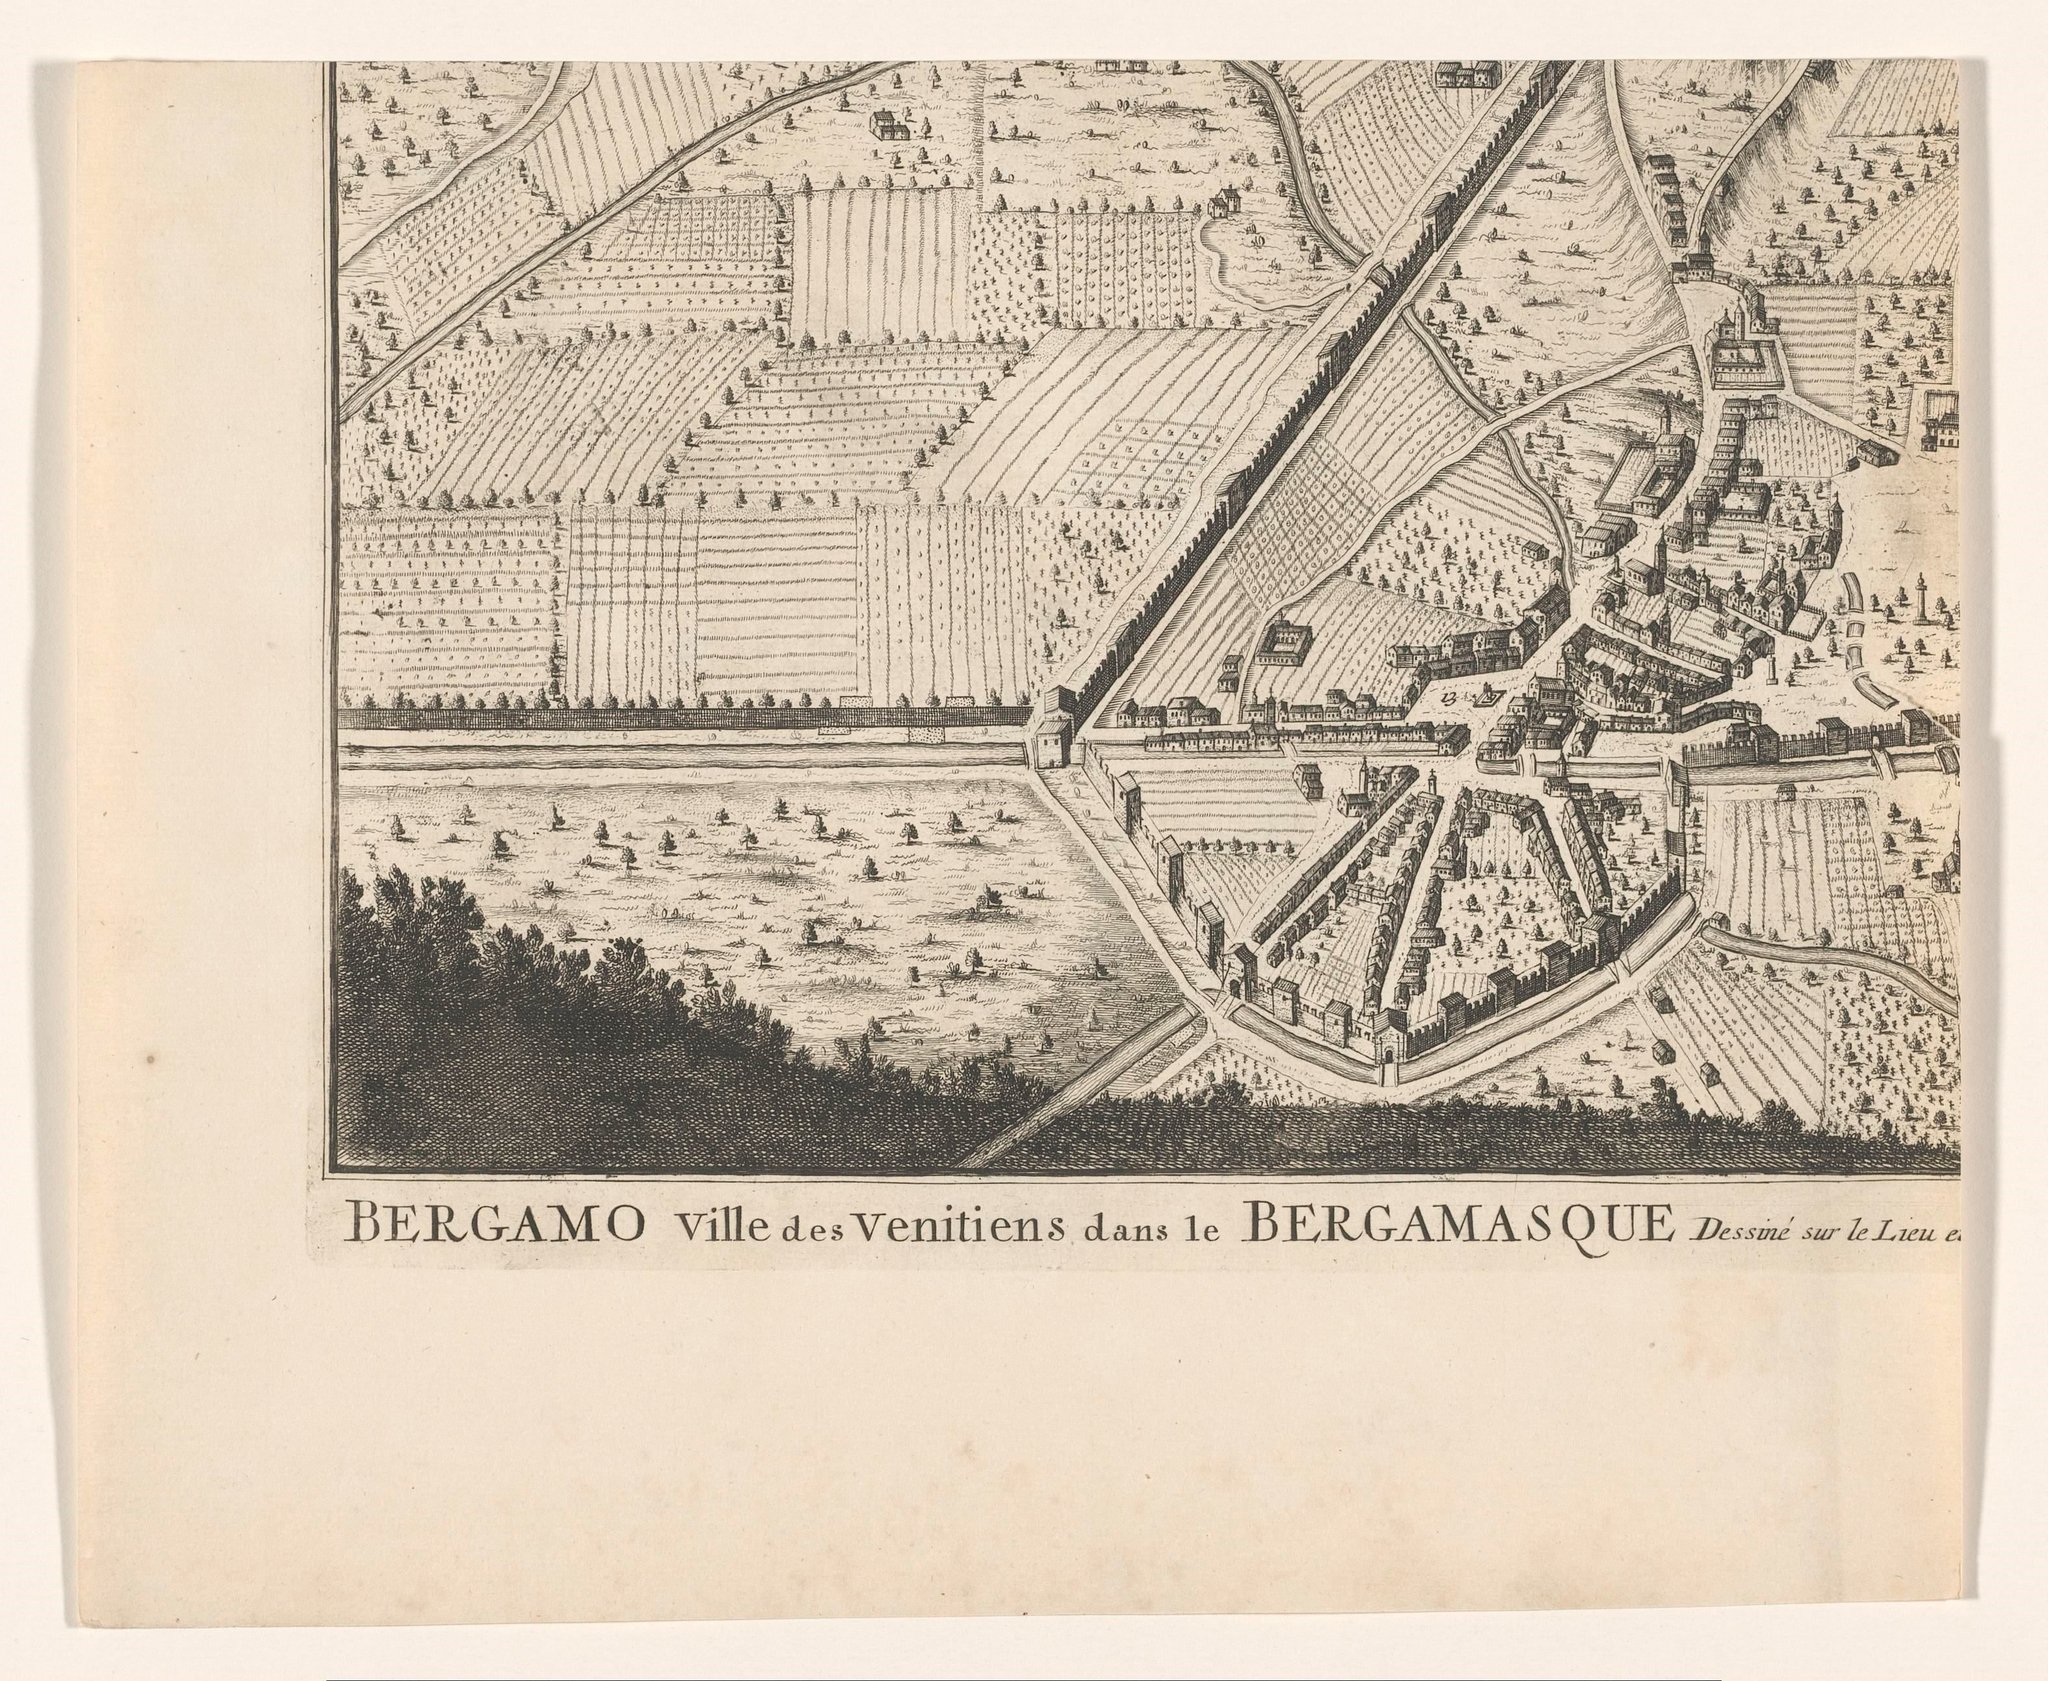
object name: print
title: Bergamo ville des Venitiens dans le Bergamasque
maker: Anonymous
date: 1704-1724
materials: paper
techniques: engraving, etching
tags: maps of cities, prospect of city, town panorama, silhouette of city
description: Plattegrond van Bergamo, gesneden in vier delen. Op deel rechtsboven genummerd: XXVII.